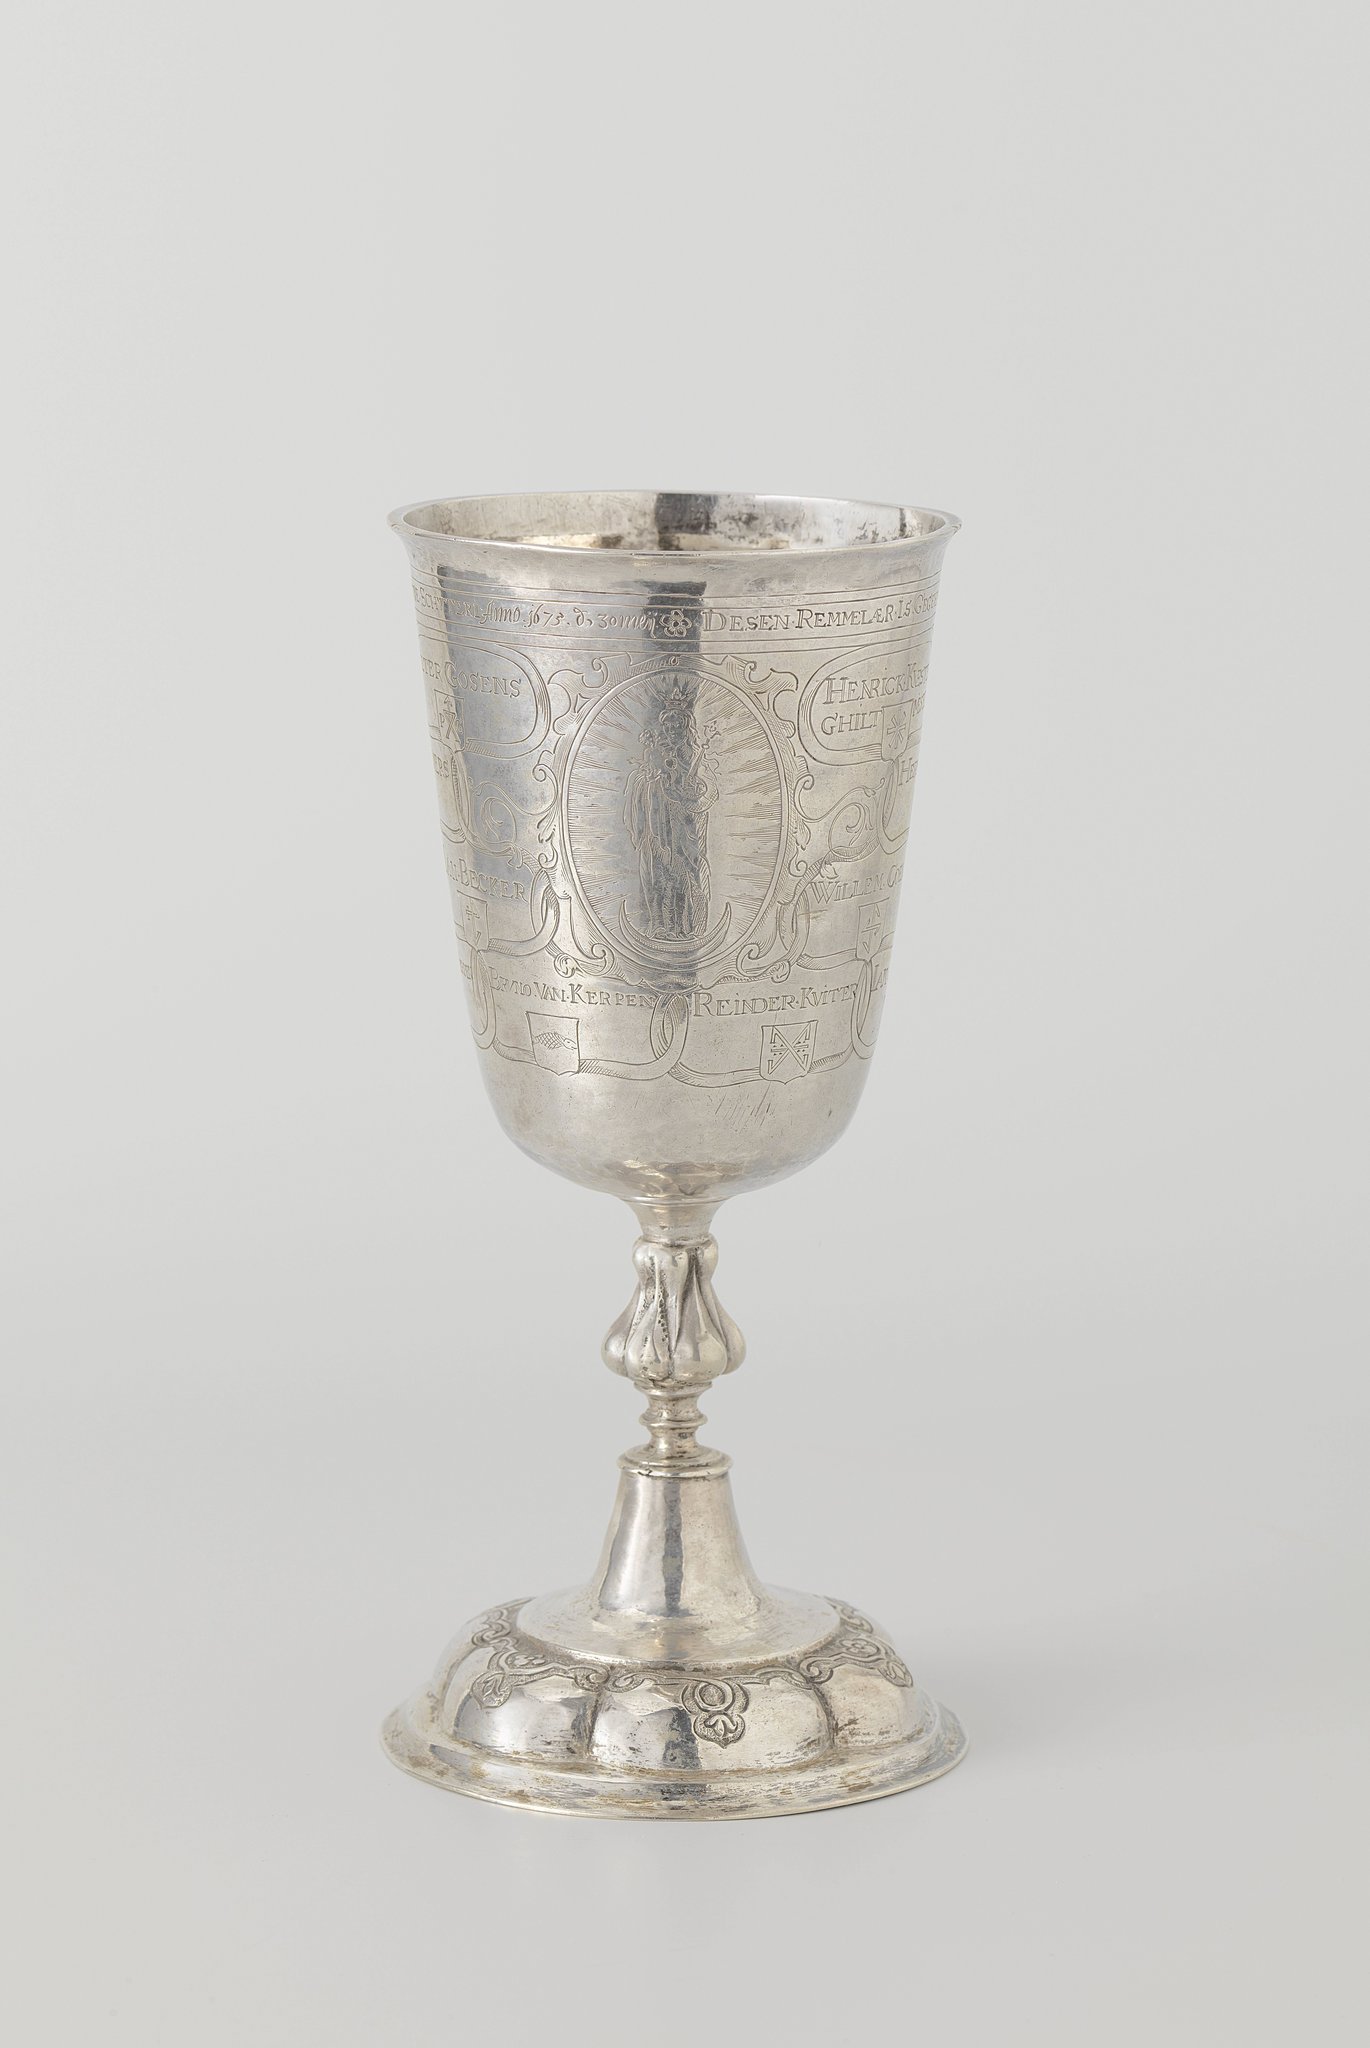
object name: cup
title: Beker van een broederschap te Emmerich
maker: Anonymous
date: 1675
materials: silver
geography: rhineland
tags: madonna on the crescent of the moon (sometimes called queen of heaven) (in mandorla)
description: Gildebeker van zilver, op een ronde zeslobbige voet. Om de gehele kelk geslingerd bandwerk, waartussen schilden met huismerken en namen.